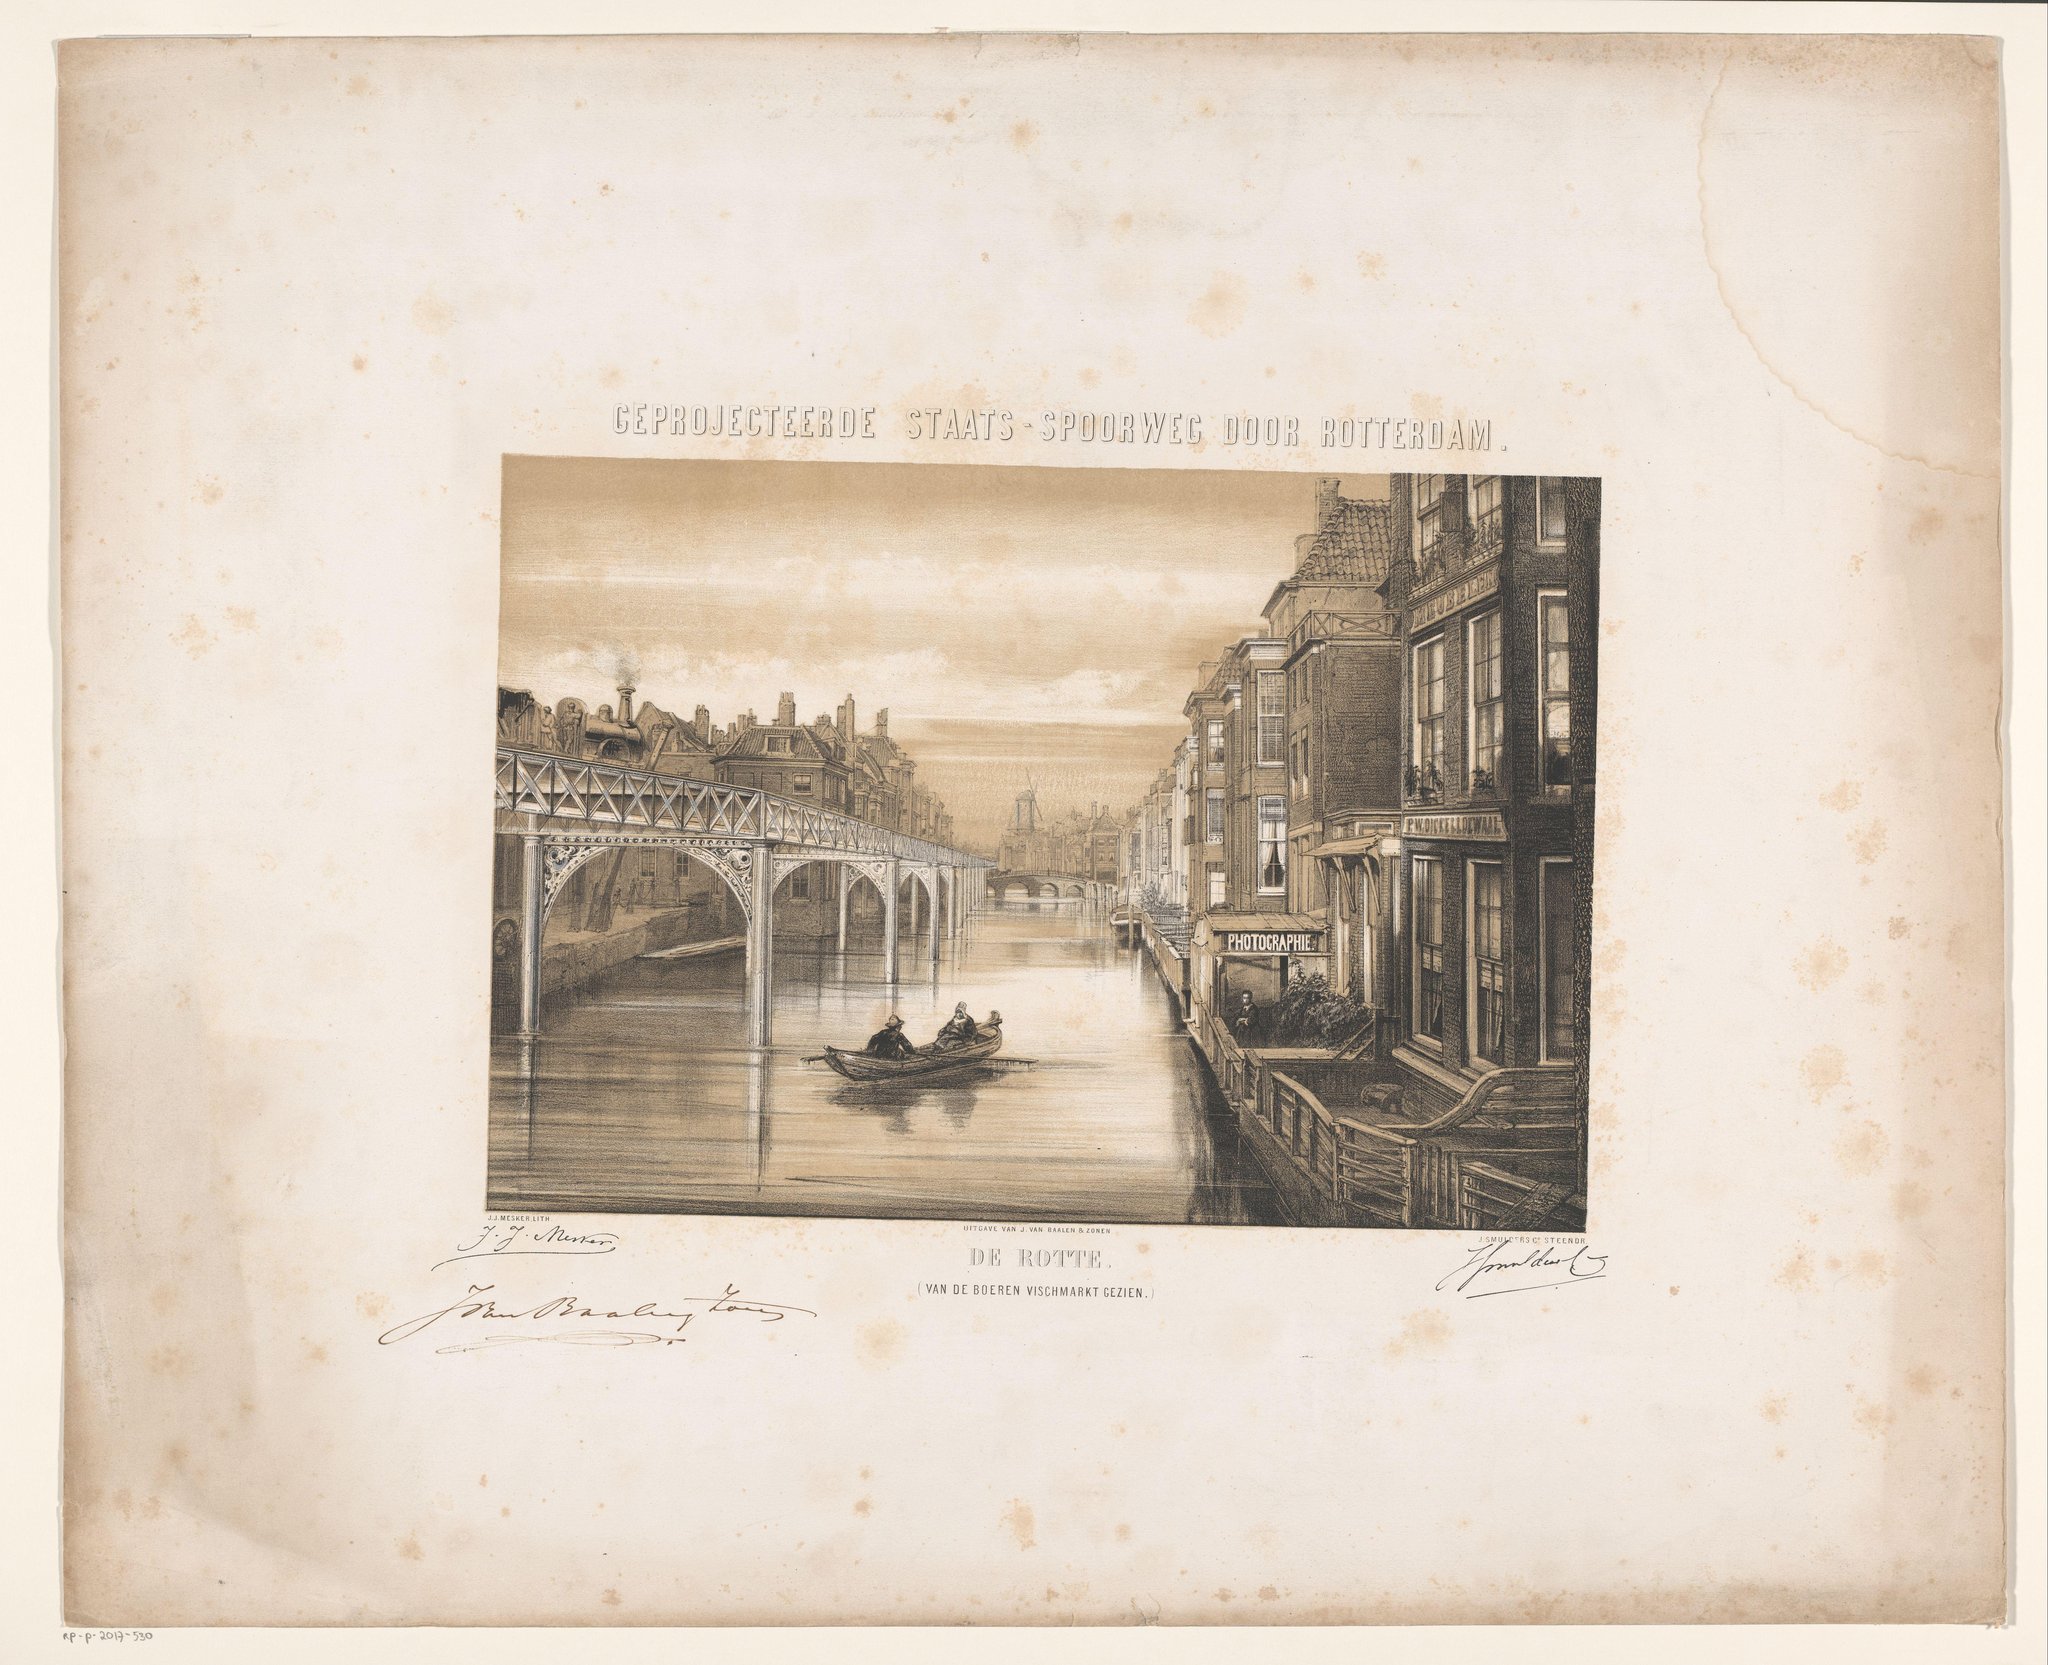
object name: print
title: De Rotte (van de boeren vischmarkt gezien)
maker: jan mesker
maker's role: print maker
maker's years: 1843-1890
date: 1864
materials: paper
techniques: tone lithography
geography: rotterdam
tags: canals, waters (in city), railway, tramway; rack railway, rotterdam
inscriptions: : ‘J.J. Mesker J. Smulders & Co / J. van Baalen en zonen’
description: Maakt deel uit van een serie van zeven prenten.